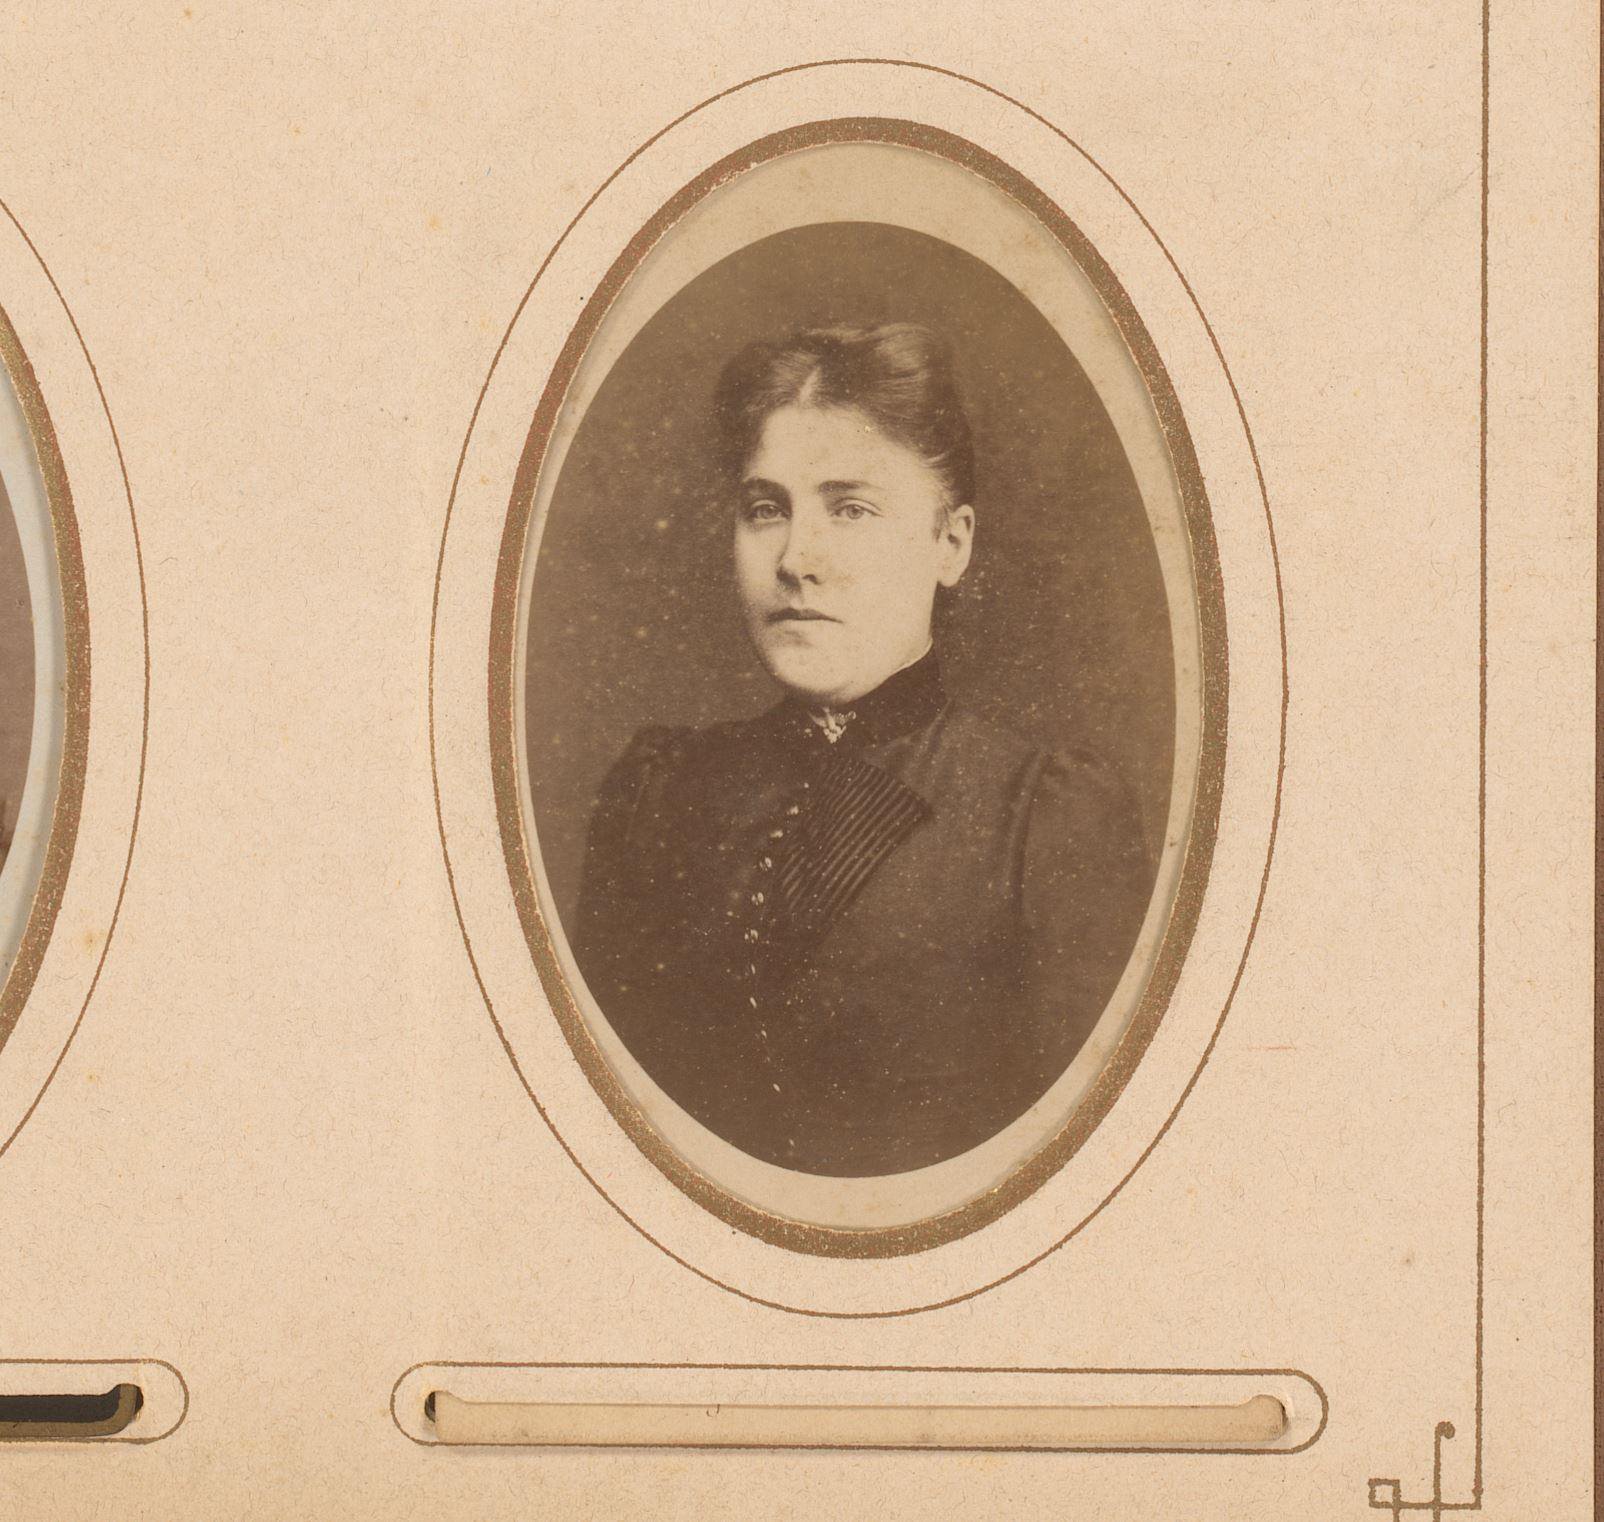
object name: album leaf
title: Portret van een vrouw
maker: Anonymous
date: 1860-1890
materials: cardboard, photographic support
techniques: albumen print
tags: historical persons - bb - woman